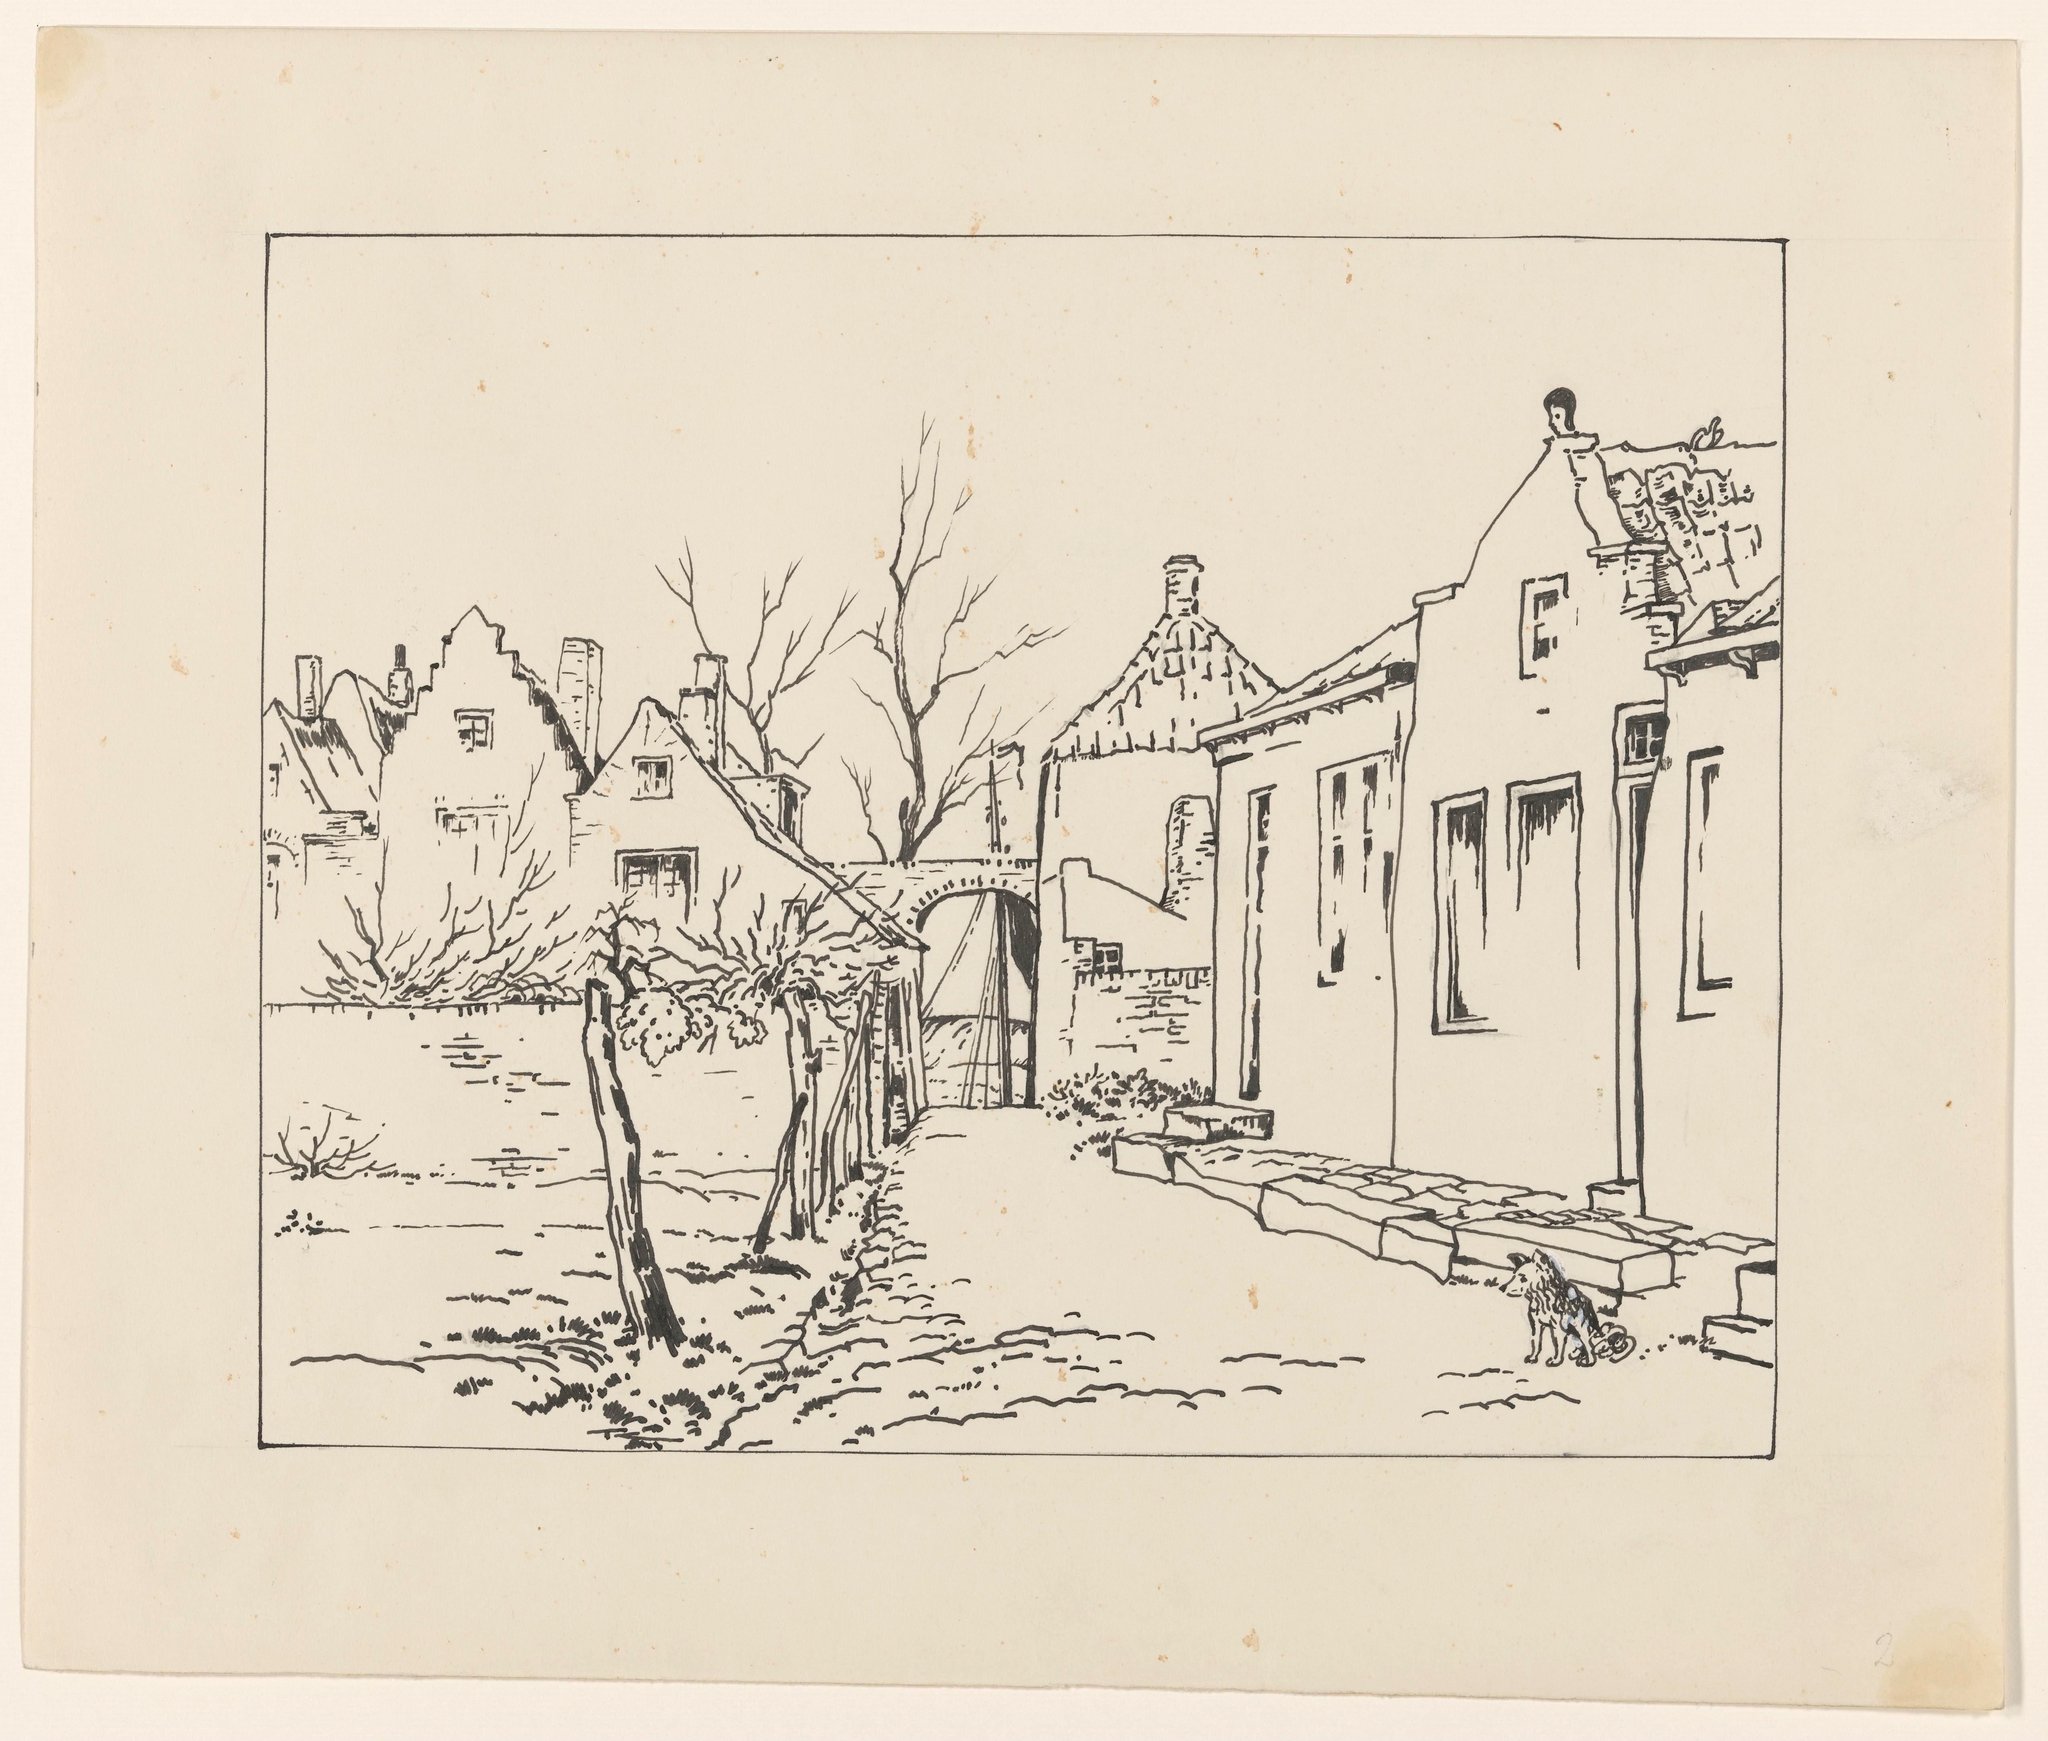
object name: drawing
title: Buurtje te Veere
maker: johannes frederik engelbert ten klooster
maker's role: draughtsman, print maker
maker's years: 1873-1940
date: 1883-1940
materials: ink, paper, pencil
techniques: pen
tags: public road